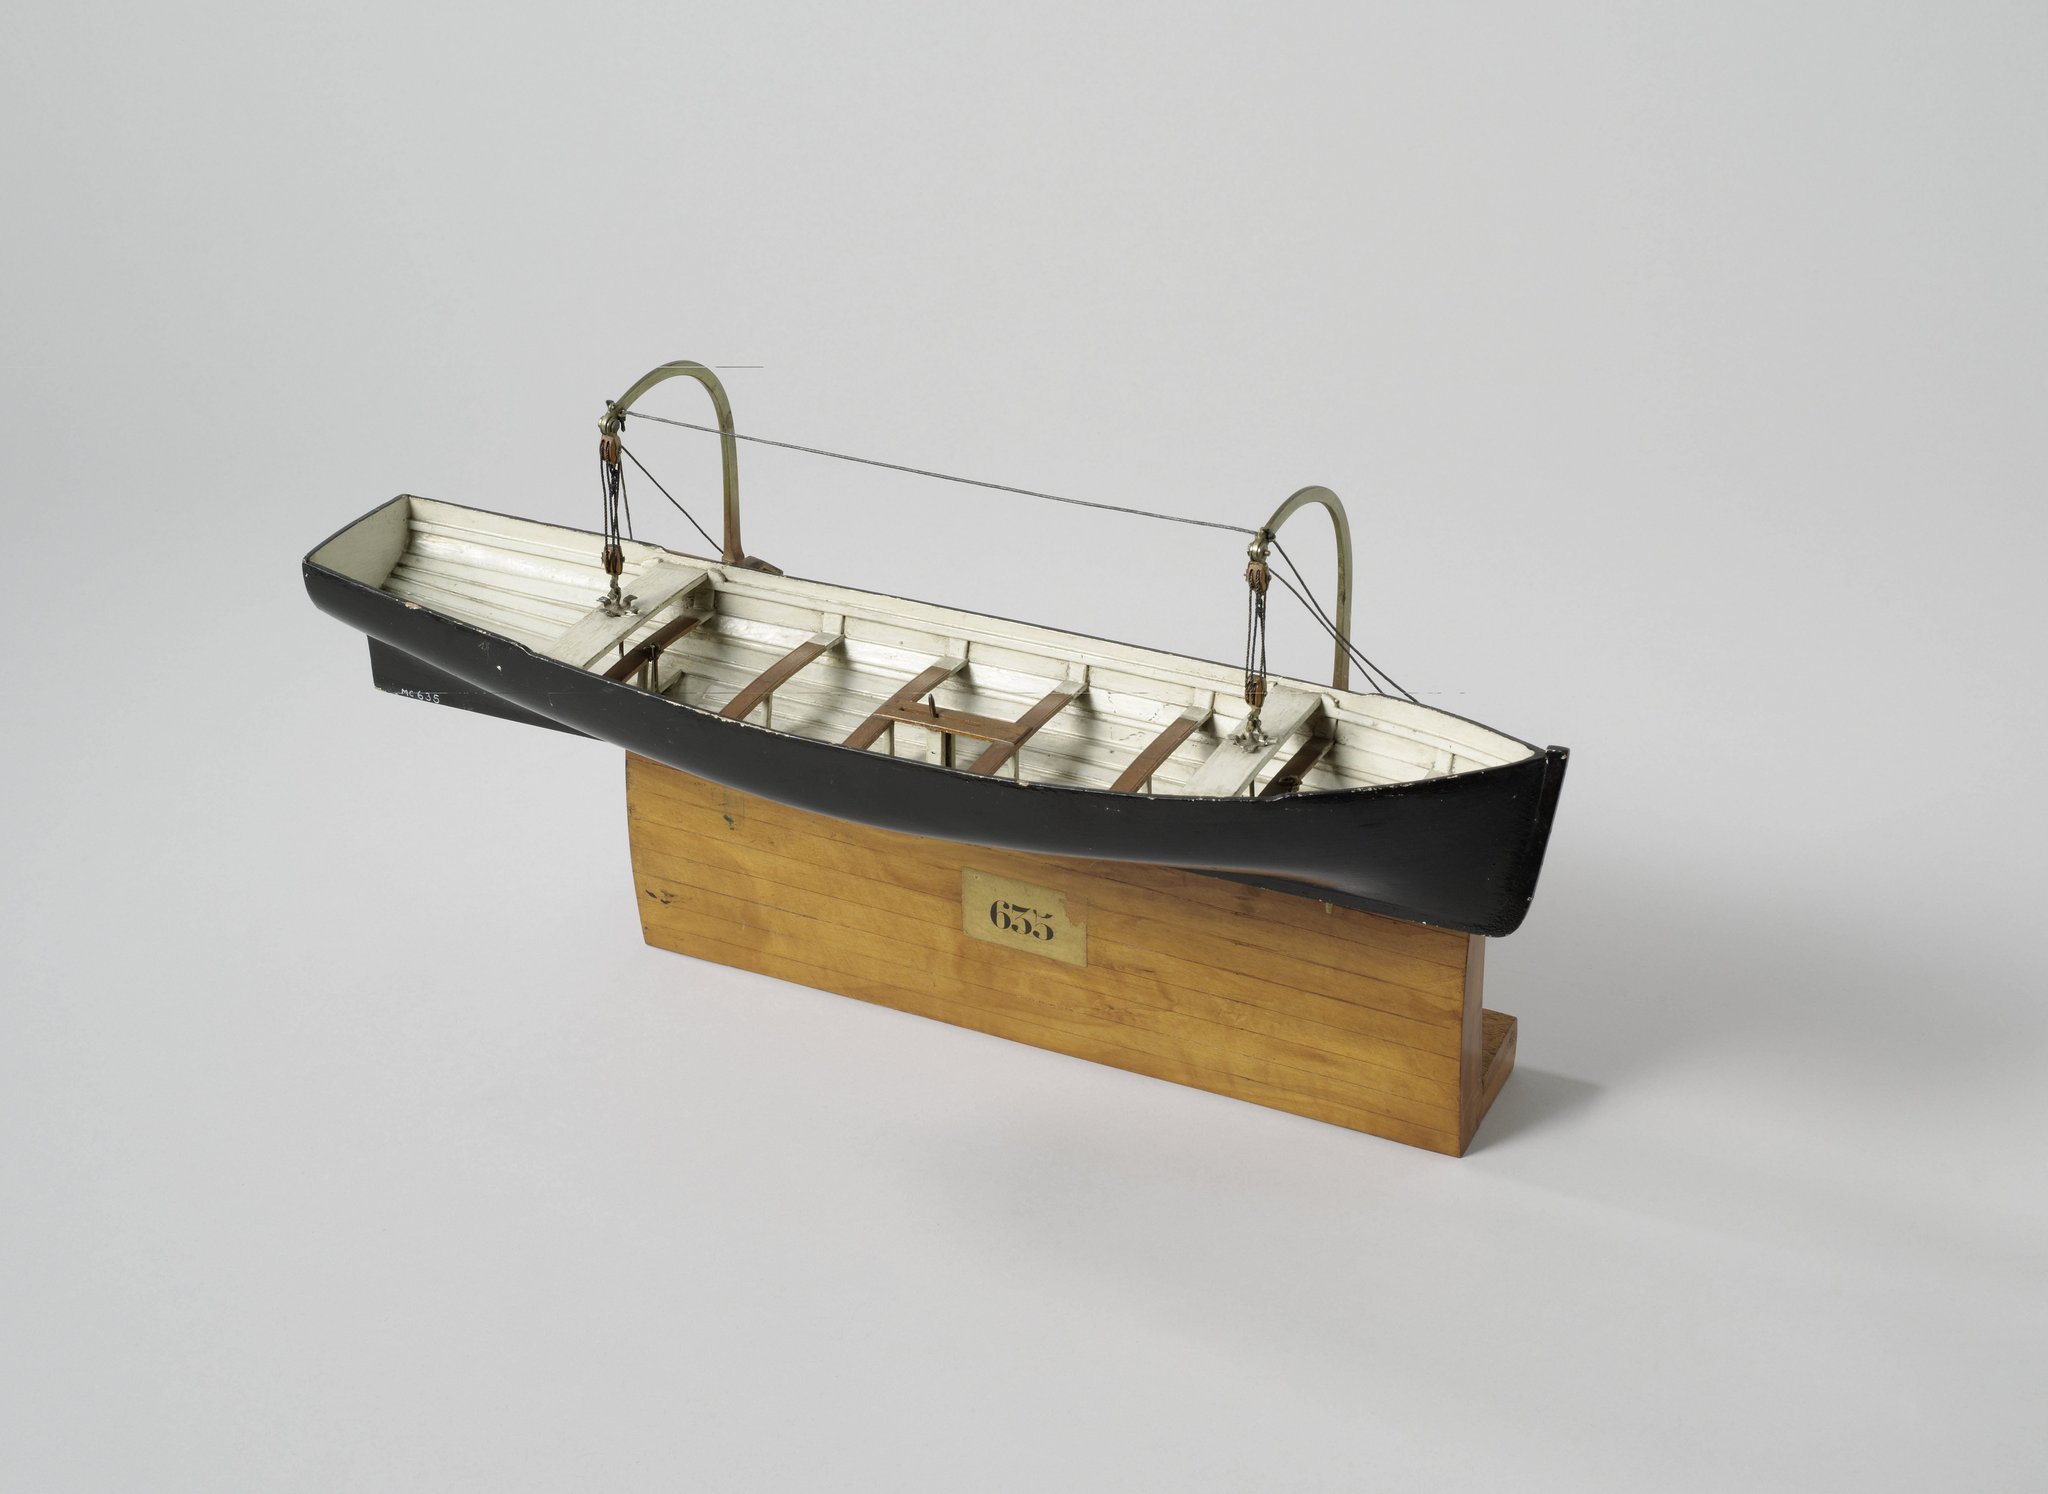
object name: demonstration model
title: Model of a Lifeboat Release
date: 1857-1858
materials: brass, fiber, wood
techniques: polychromy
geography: flushing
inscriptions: label: ‘635’ former inventory label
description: Model van een deel van een scheepswand met een sloep aan twee spijkerdavits. Het model demonstreert de sloepsval in de bodem van de sloep, waarbij twee haken aan het takel van de davits worden losgelaten door middel van een hendel in het midden. De sloep is een gladboordige dubbelriems sloep met platte spiegel, gepiekt rondspant en zeeg naar beide uiteinden oplopend; hij heeft zeven doften plus twee extra zware doften voor de haken.